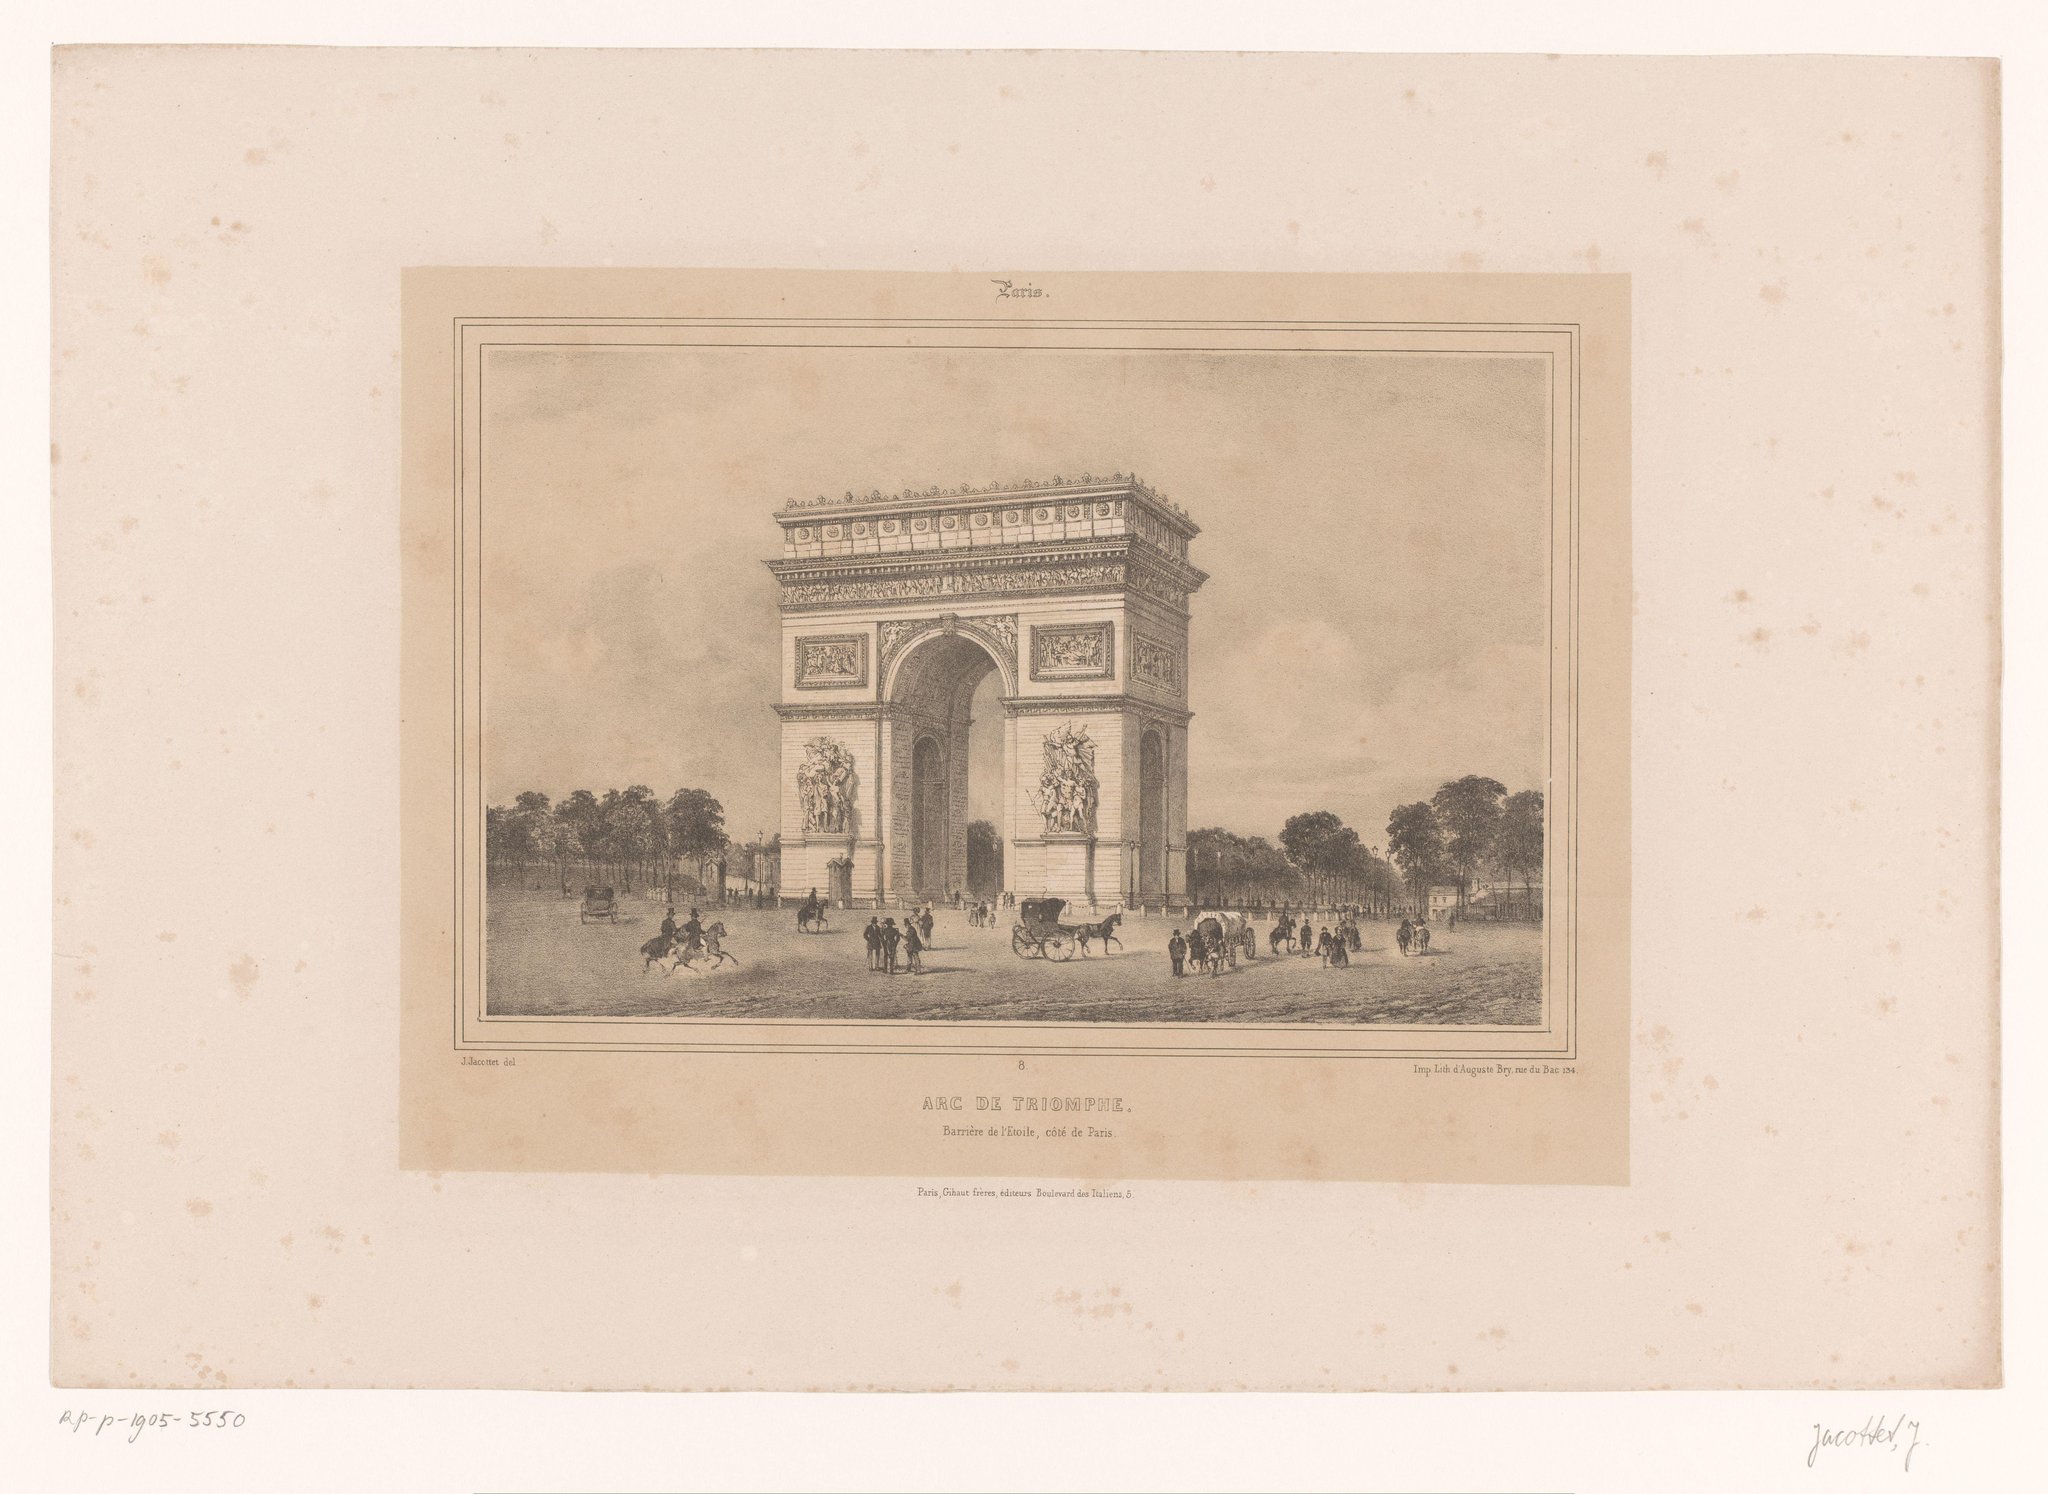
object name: print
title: Gezichten in en om Parijs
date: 1838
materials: paper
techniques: tone lithography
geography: paris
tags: triumphal arch, village square, place (+ city(-scape) with figures, staffage)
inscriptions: collector's mark: Lugt 2228a